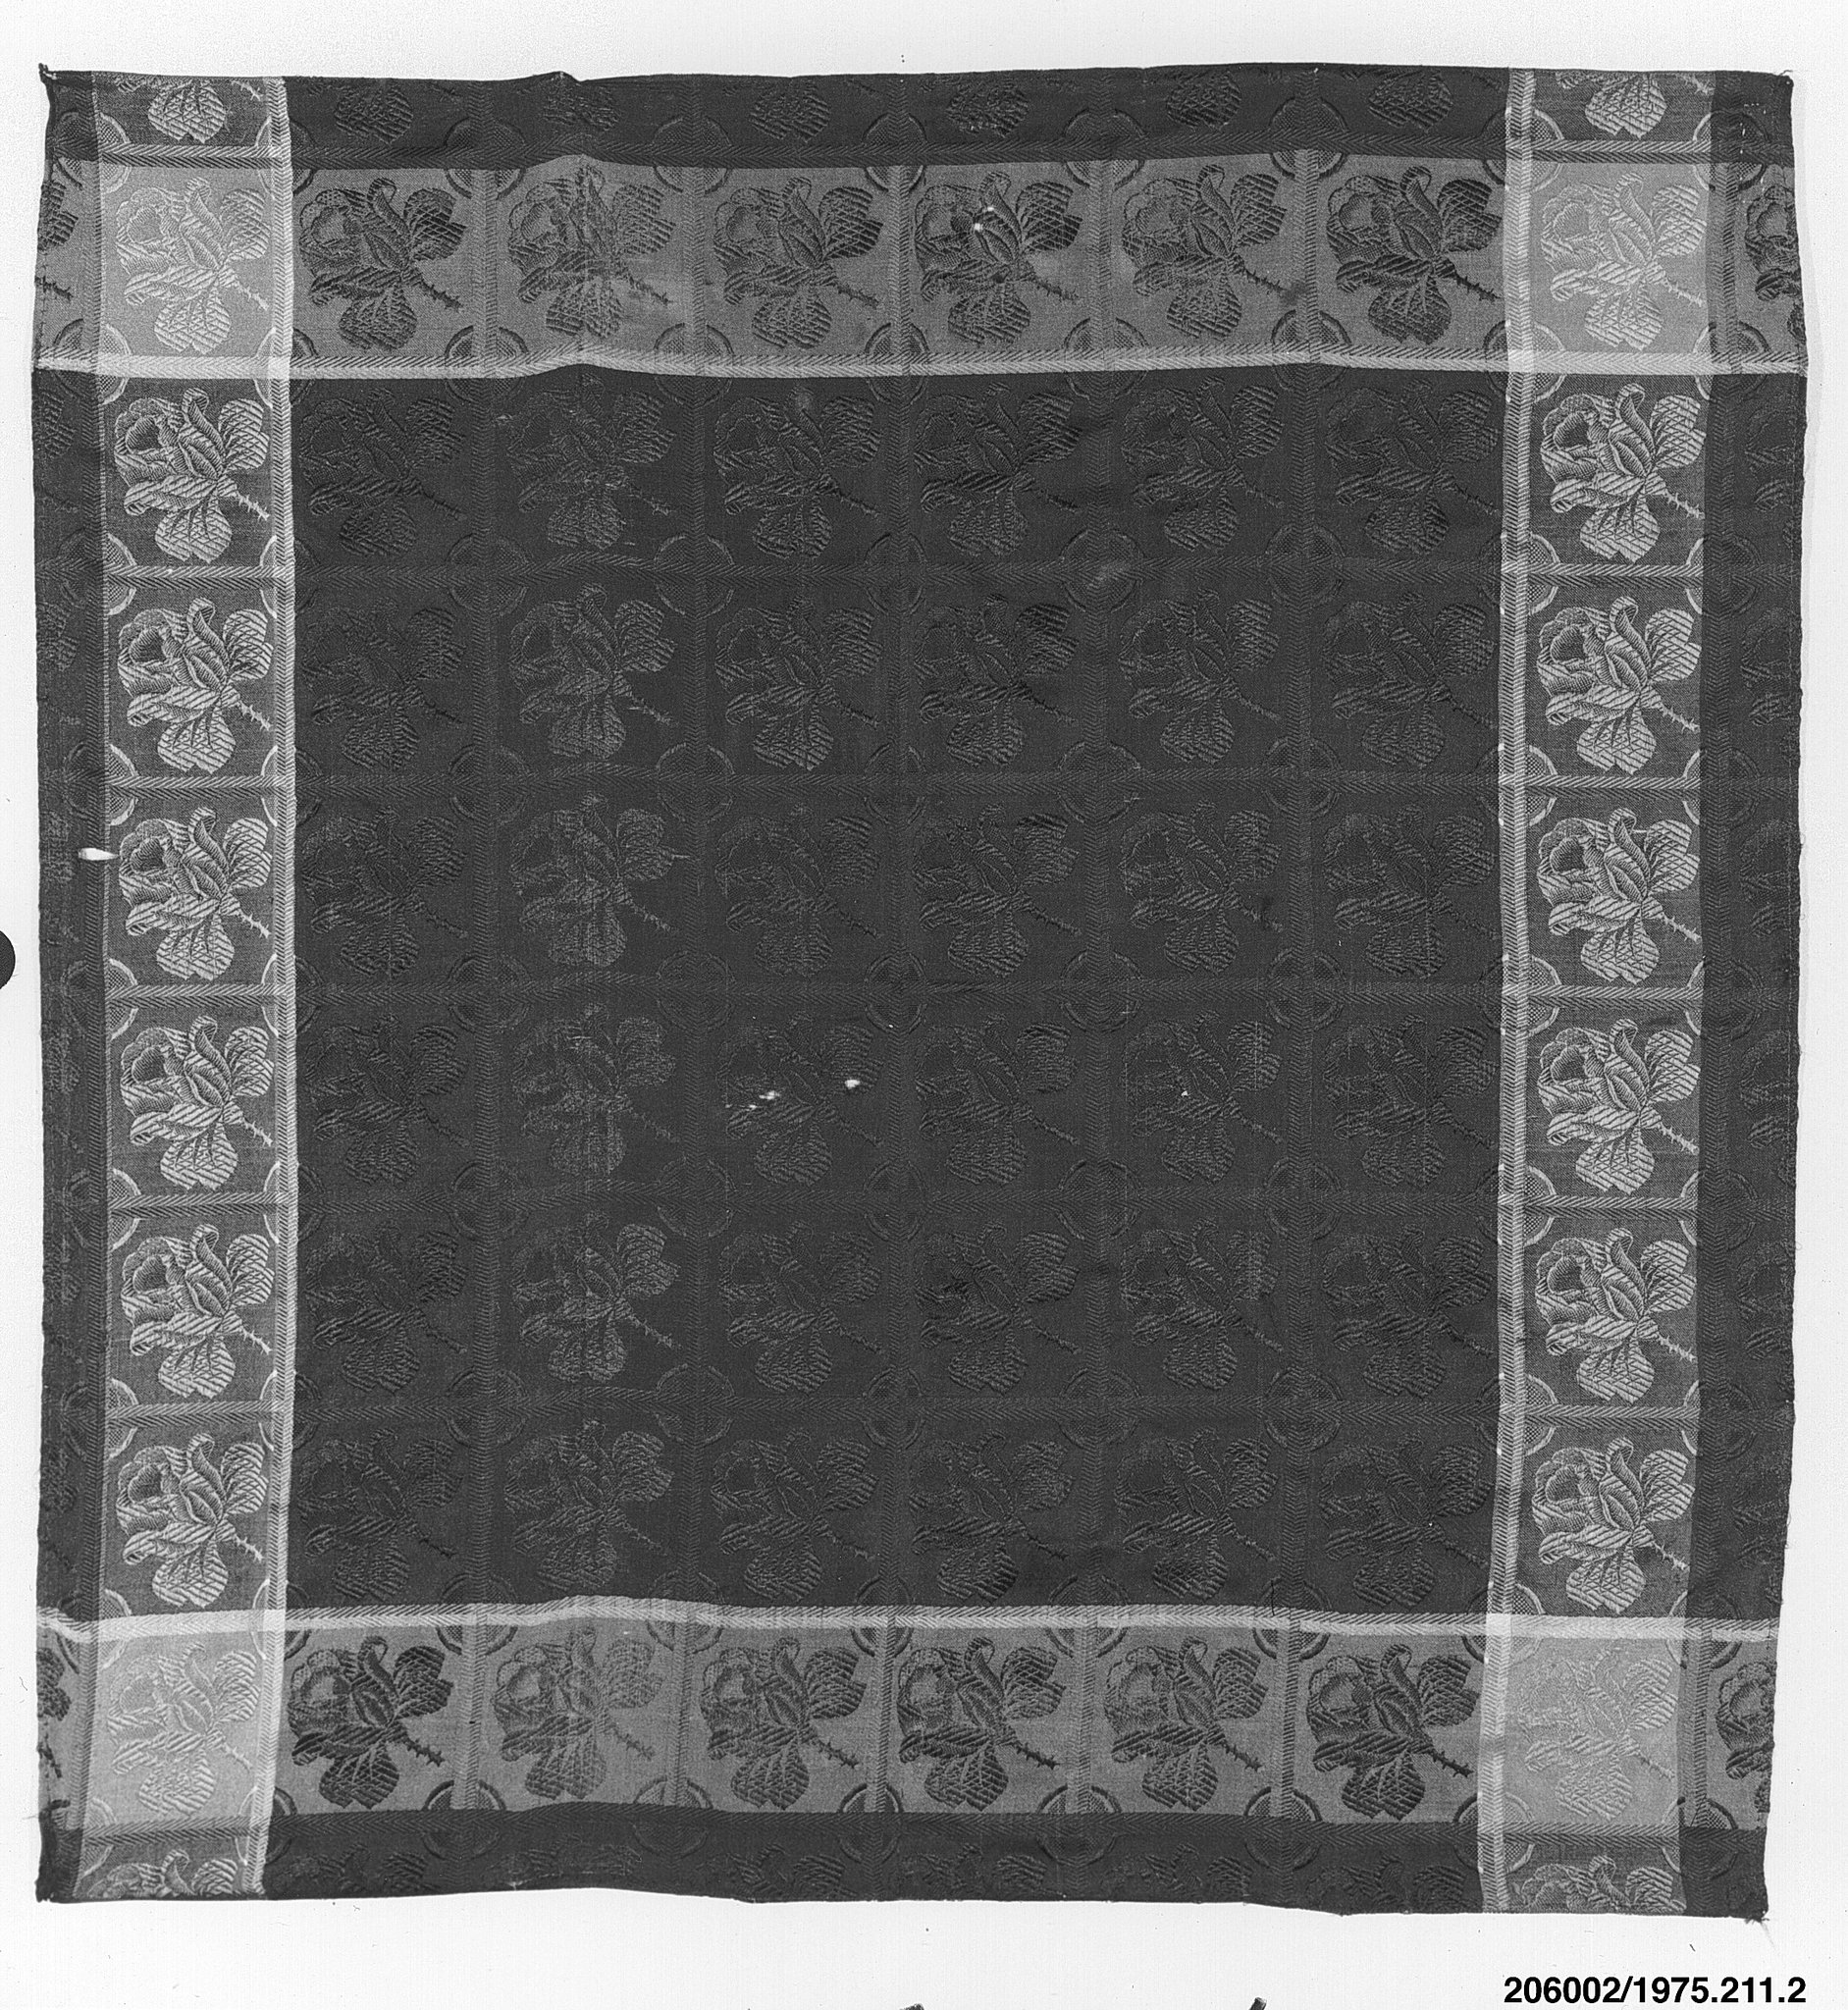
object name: handkerchief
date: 1880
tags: flowers